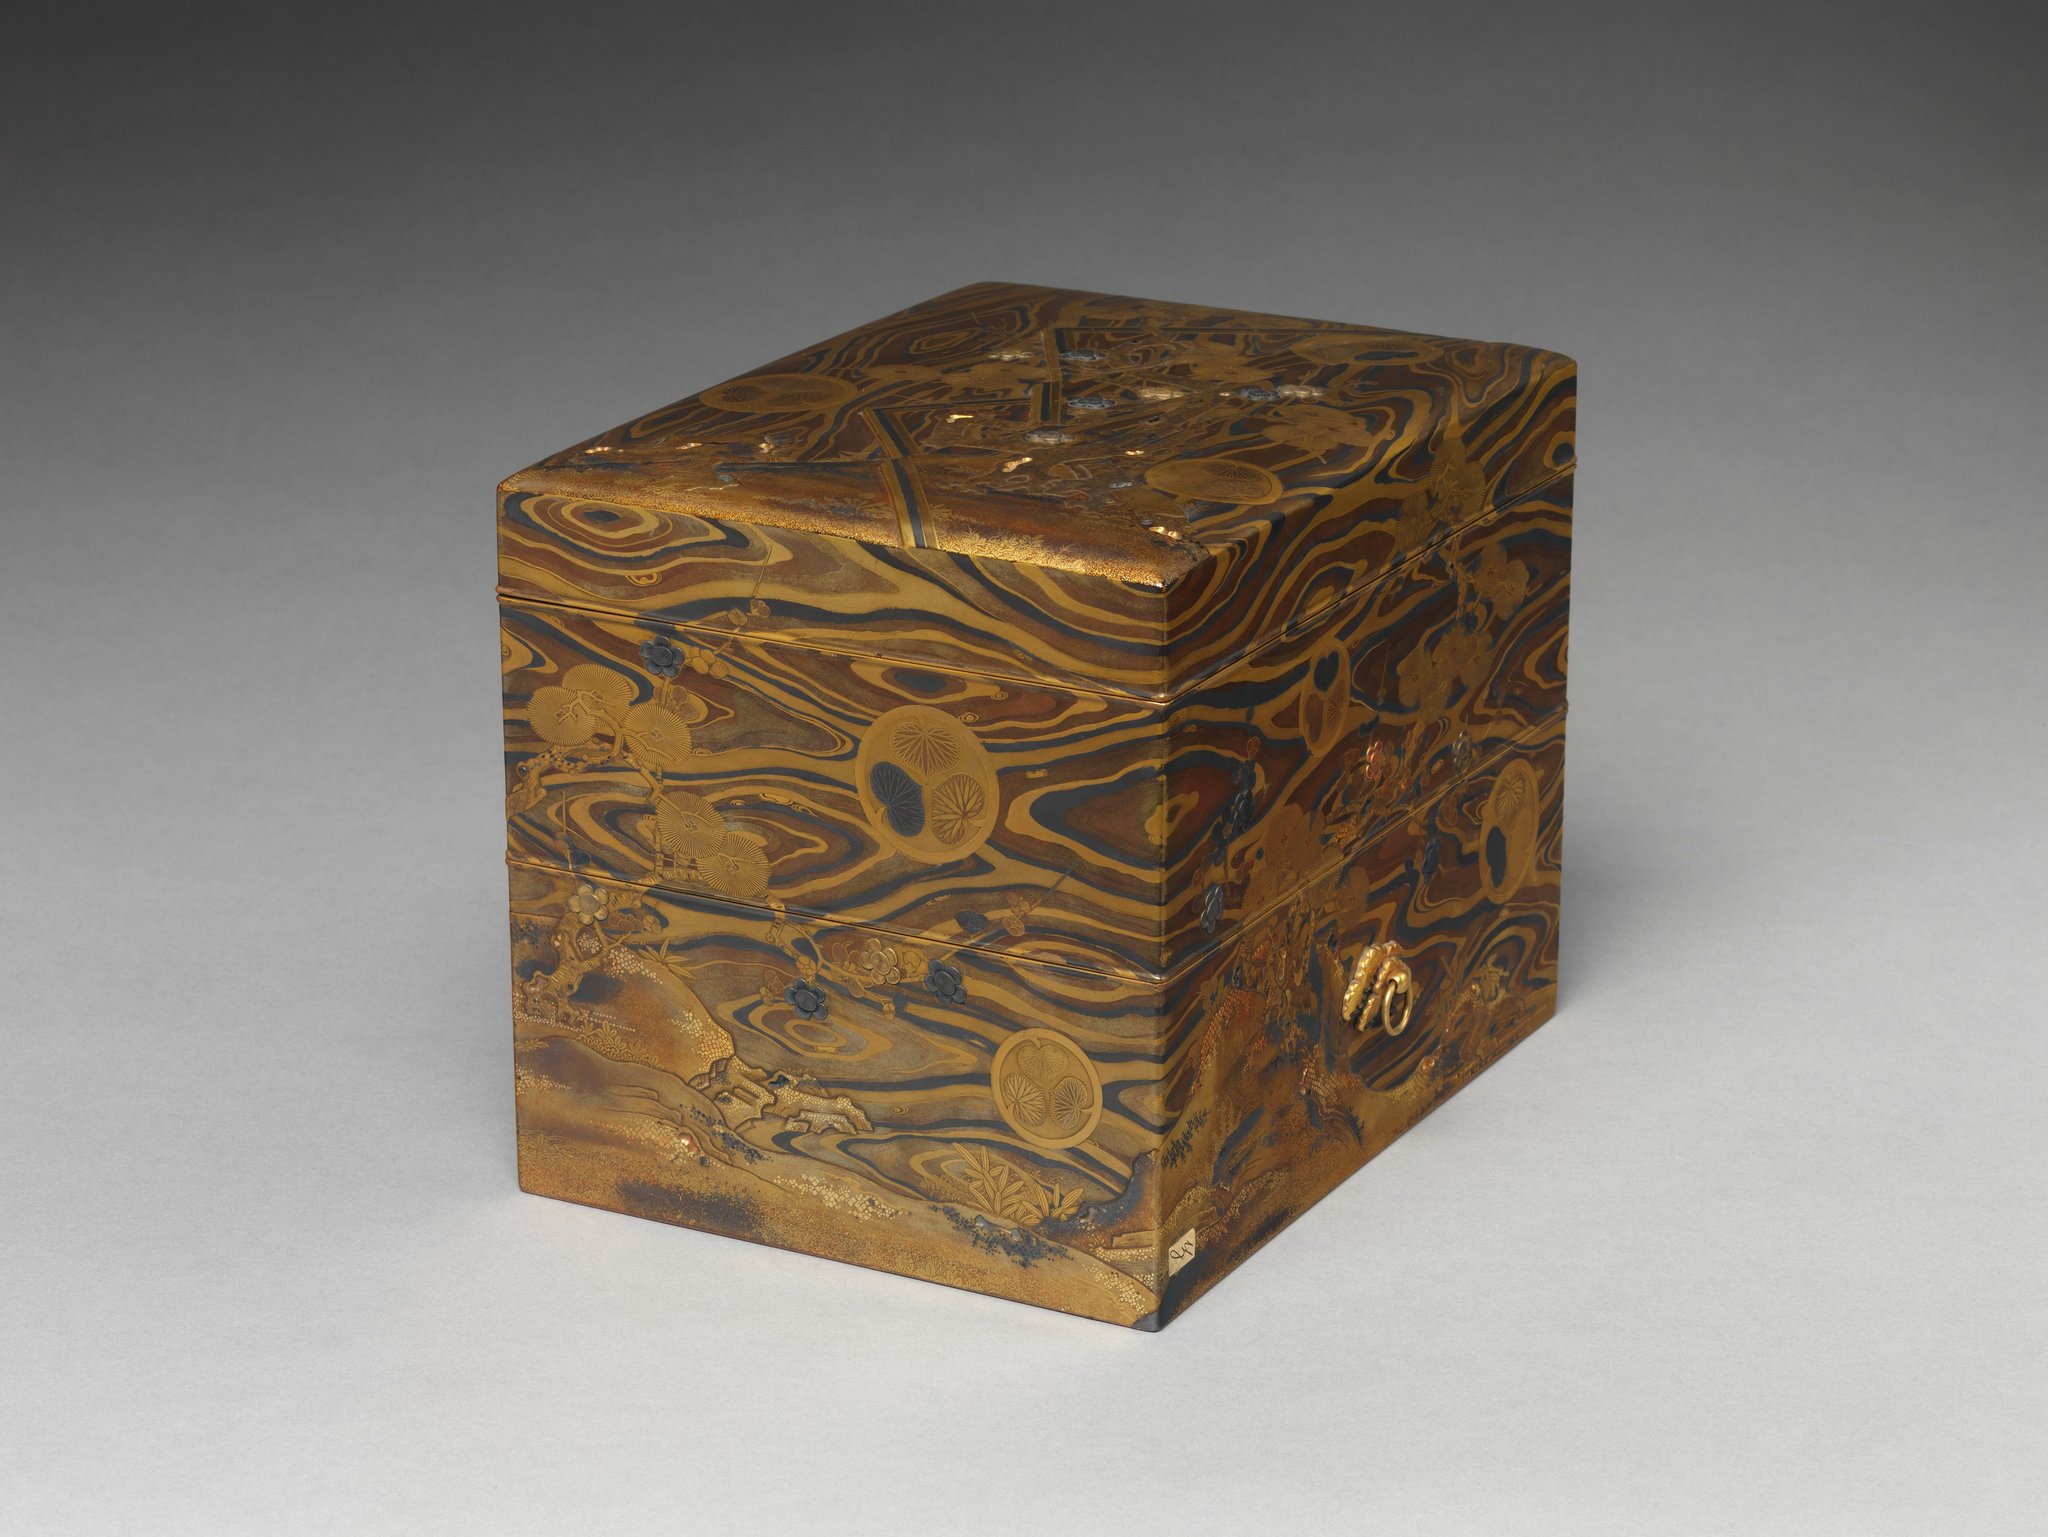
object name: box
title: Cosmetic Box (mayudzukuri-bako) with Pine, Bamboo, Plum, and Tokugawa Family Crest on Wood-Grain Ground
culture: japanese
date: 1701-1733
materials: foil, gold, lacquer, silver, wood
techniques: hiramakie, inlay, lacquer, maki-e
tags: flowers,trees